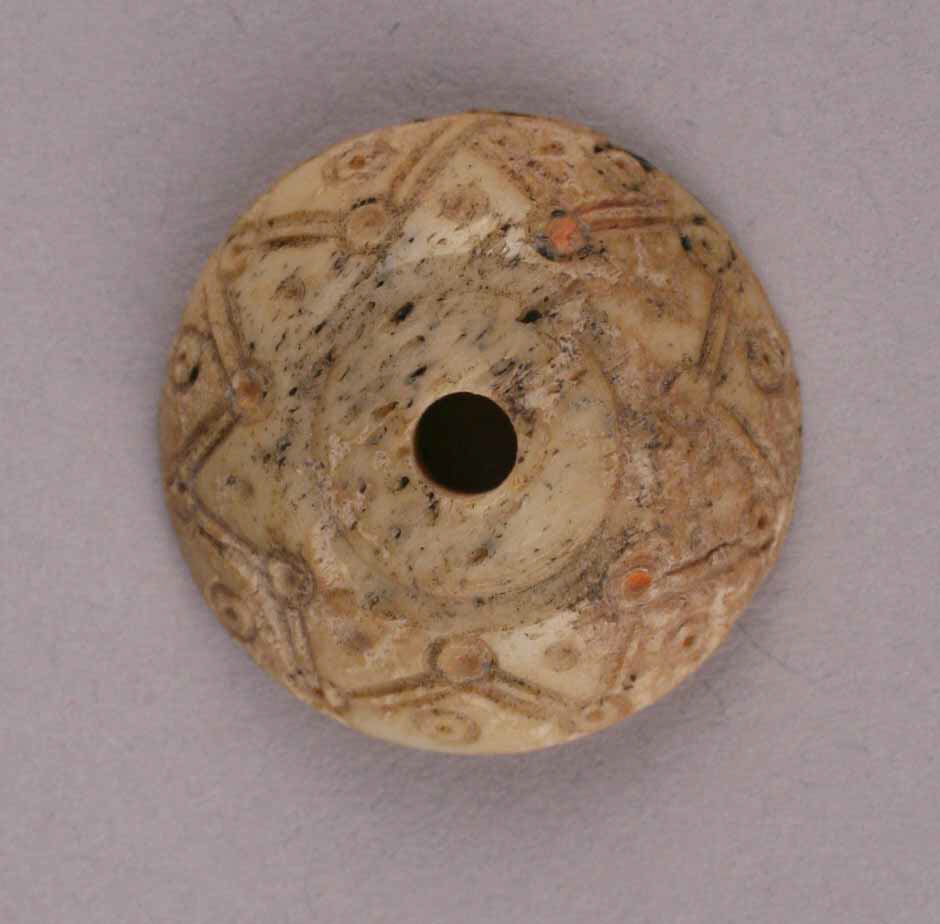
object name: button or bead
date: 801-1000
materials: bone, paint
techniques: incising, inlay, tinting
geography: iran